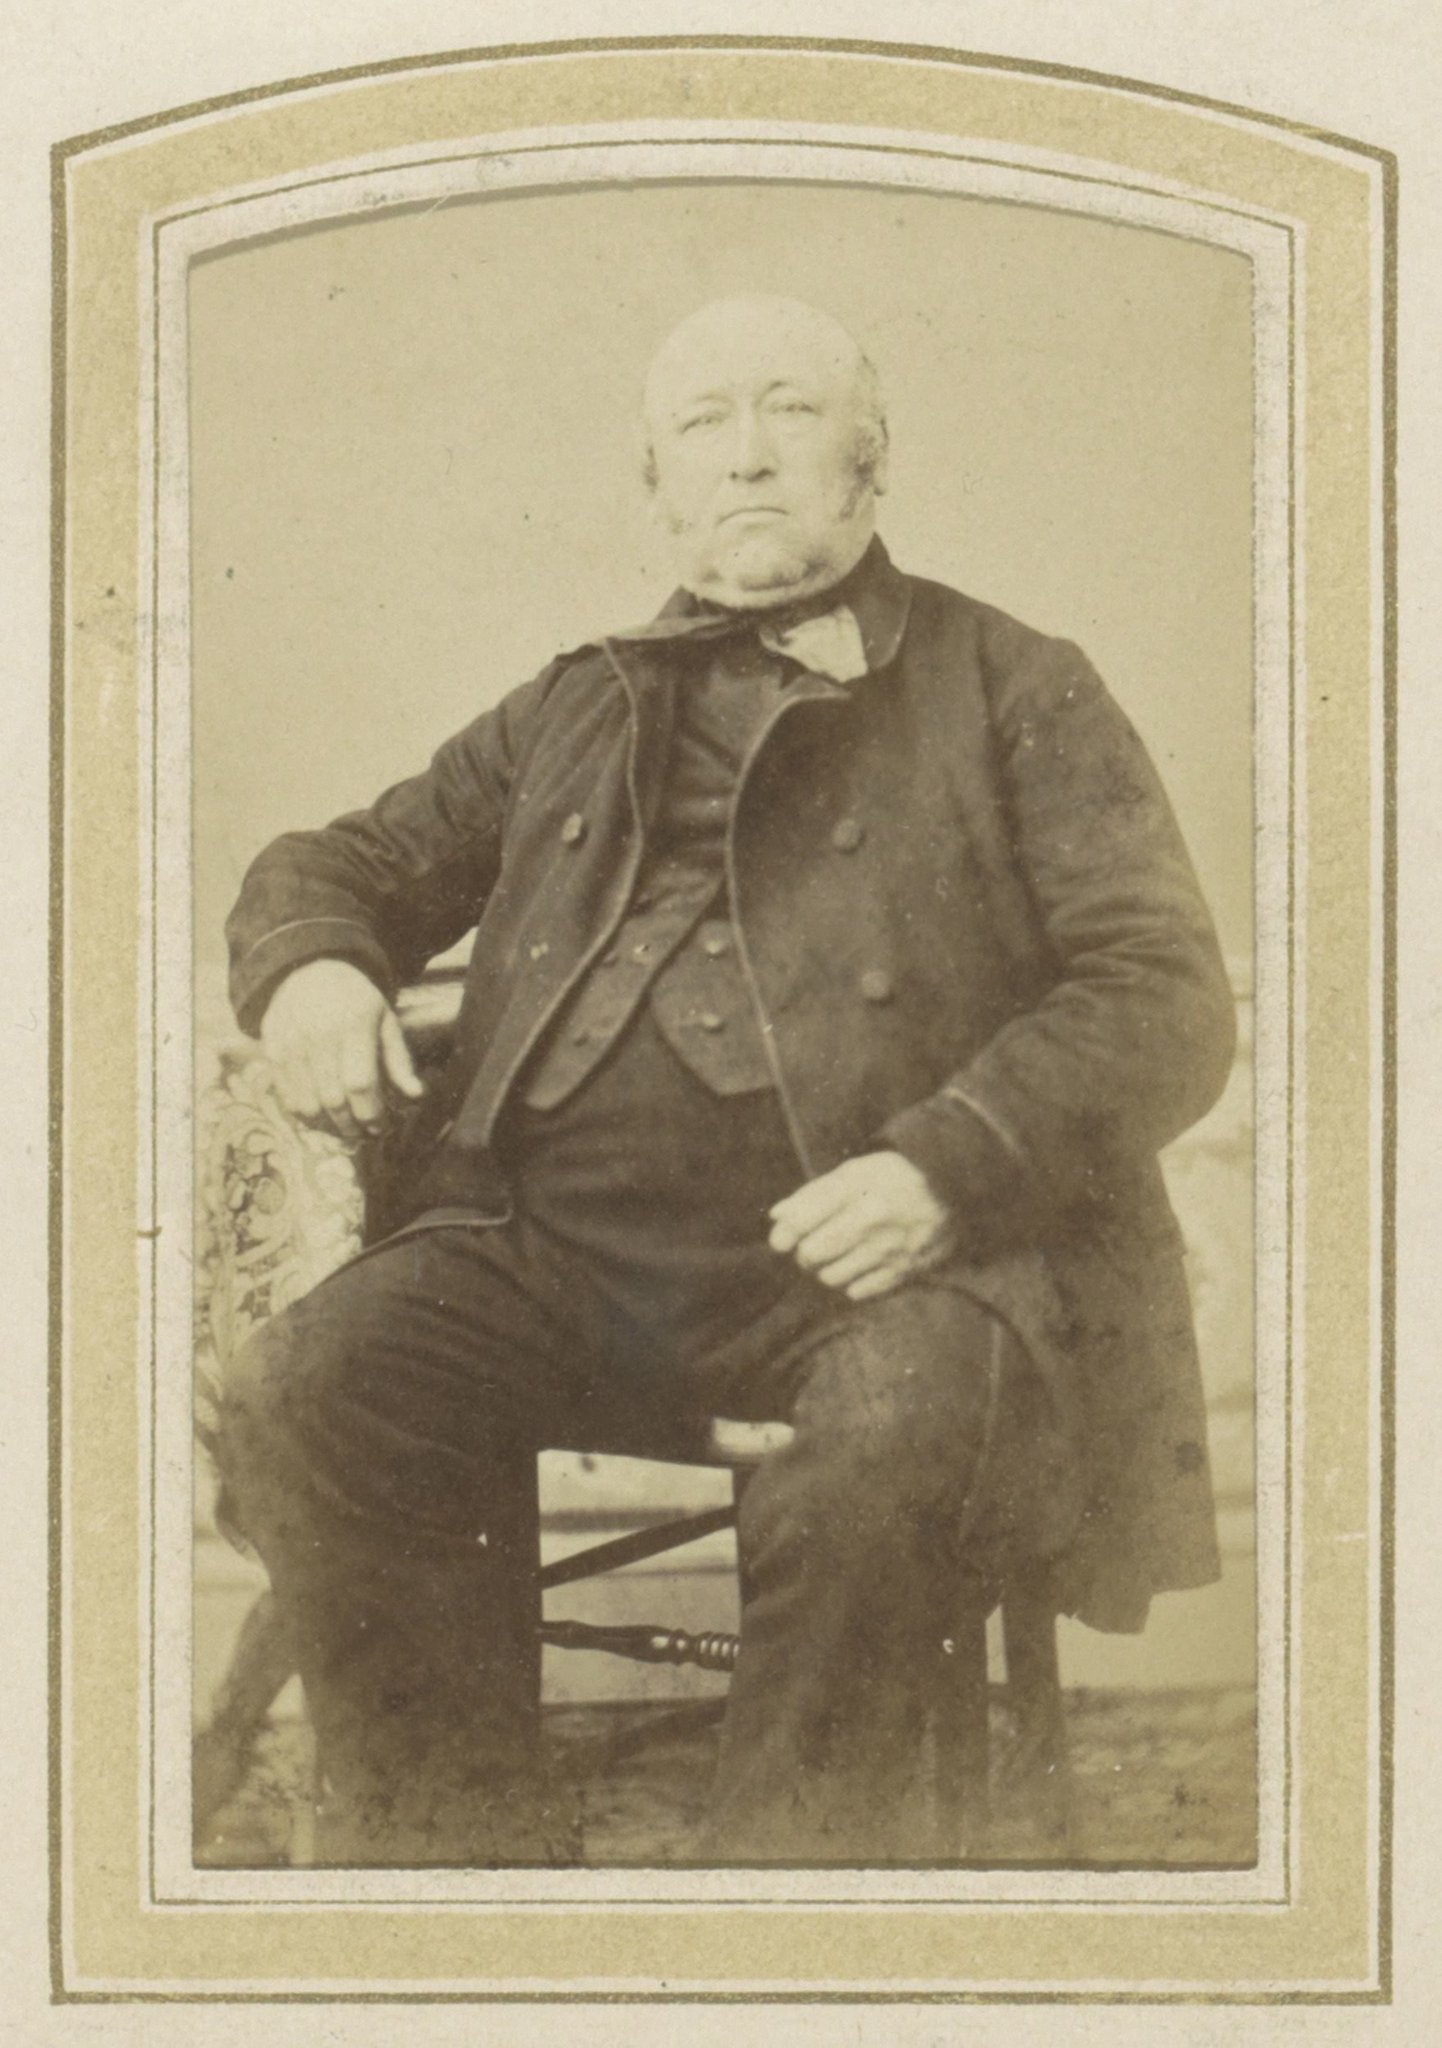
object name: photograph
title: Portret van een zittende man met een jas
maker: j.a. van krieken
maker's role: fotograaf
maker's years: 1835-1890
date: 1864-1890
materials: cardboard, paper, photographic support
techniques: albumen print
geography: tiel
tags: studio requisites ~ photographer, clothing for the lower part of the body, historical persons, clothing for the upper part of the body, coat, cape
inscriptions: address: ‘Waterstraat Tiel’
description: Onderdeel van Fotoalbum van een Nederlandse familie met 168 cartes-de-visite en kabinetfoto's.